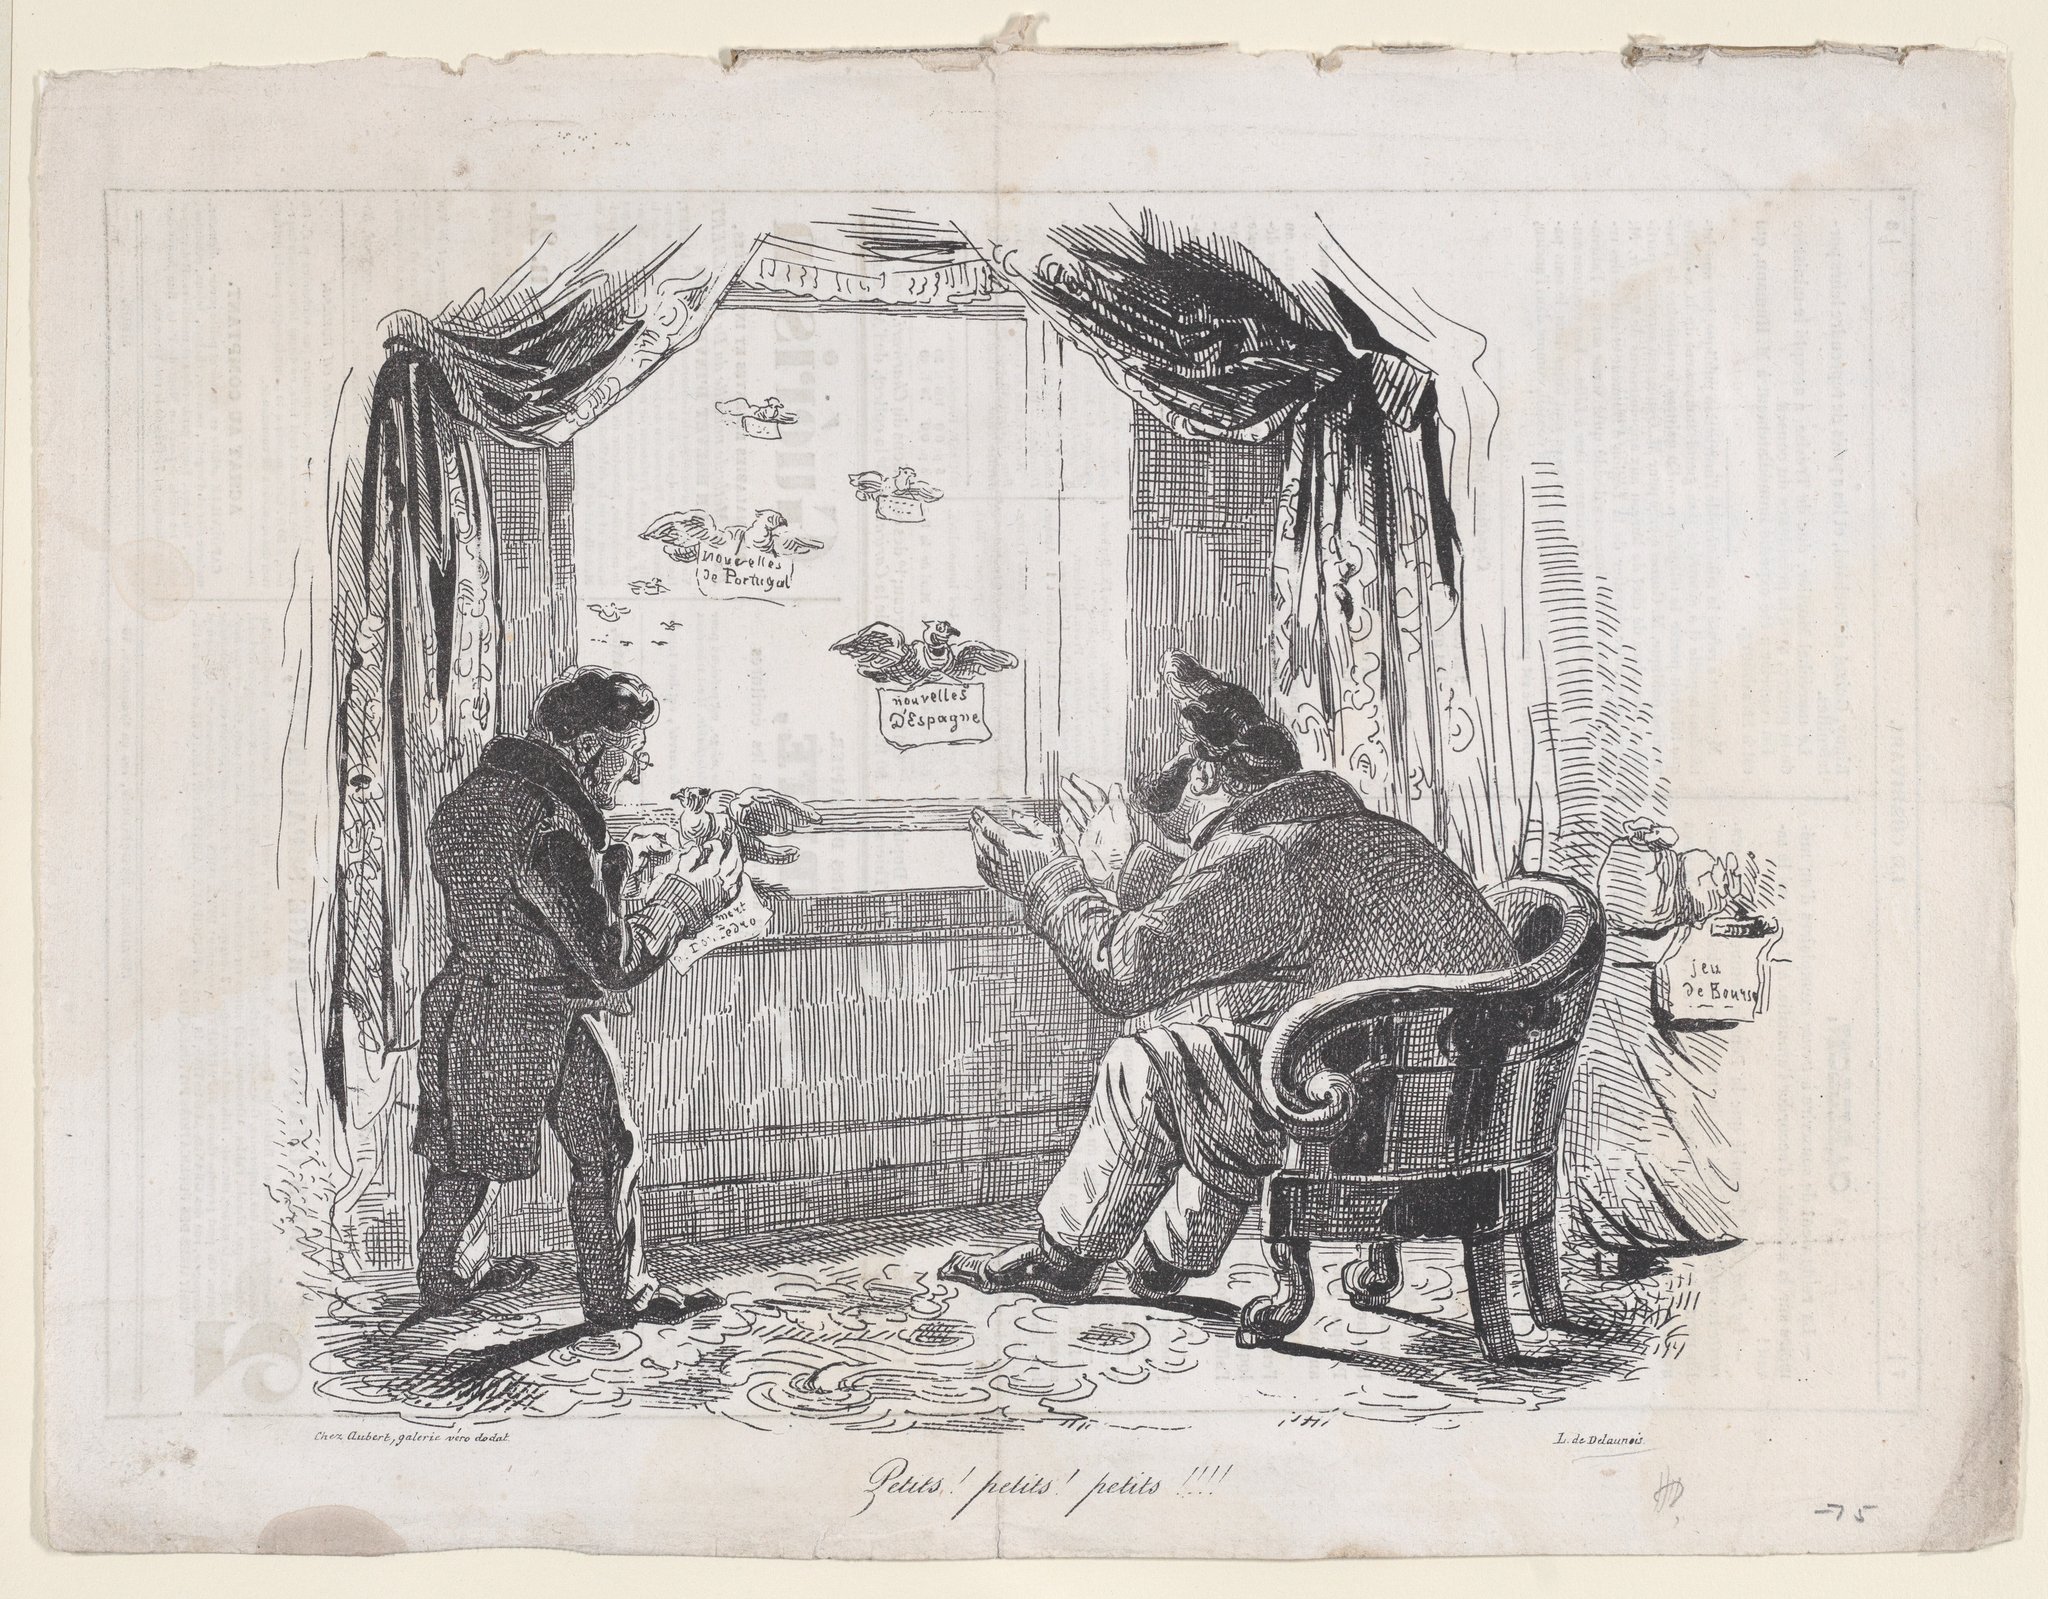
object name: print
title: Petits! petits! petits!!!!, from Le Charivari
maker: delaunois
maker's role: artist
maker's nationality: french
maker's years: 1800-1900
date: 1830-1840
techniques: lithograph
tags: birds,men